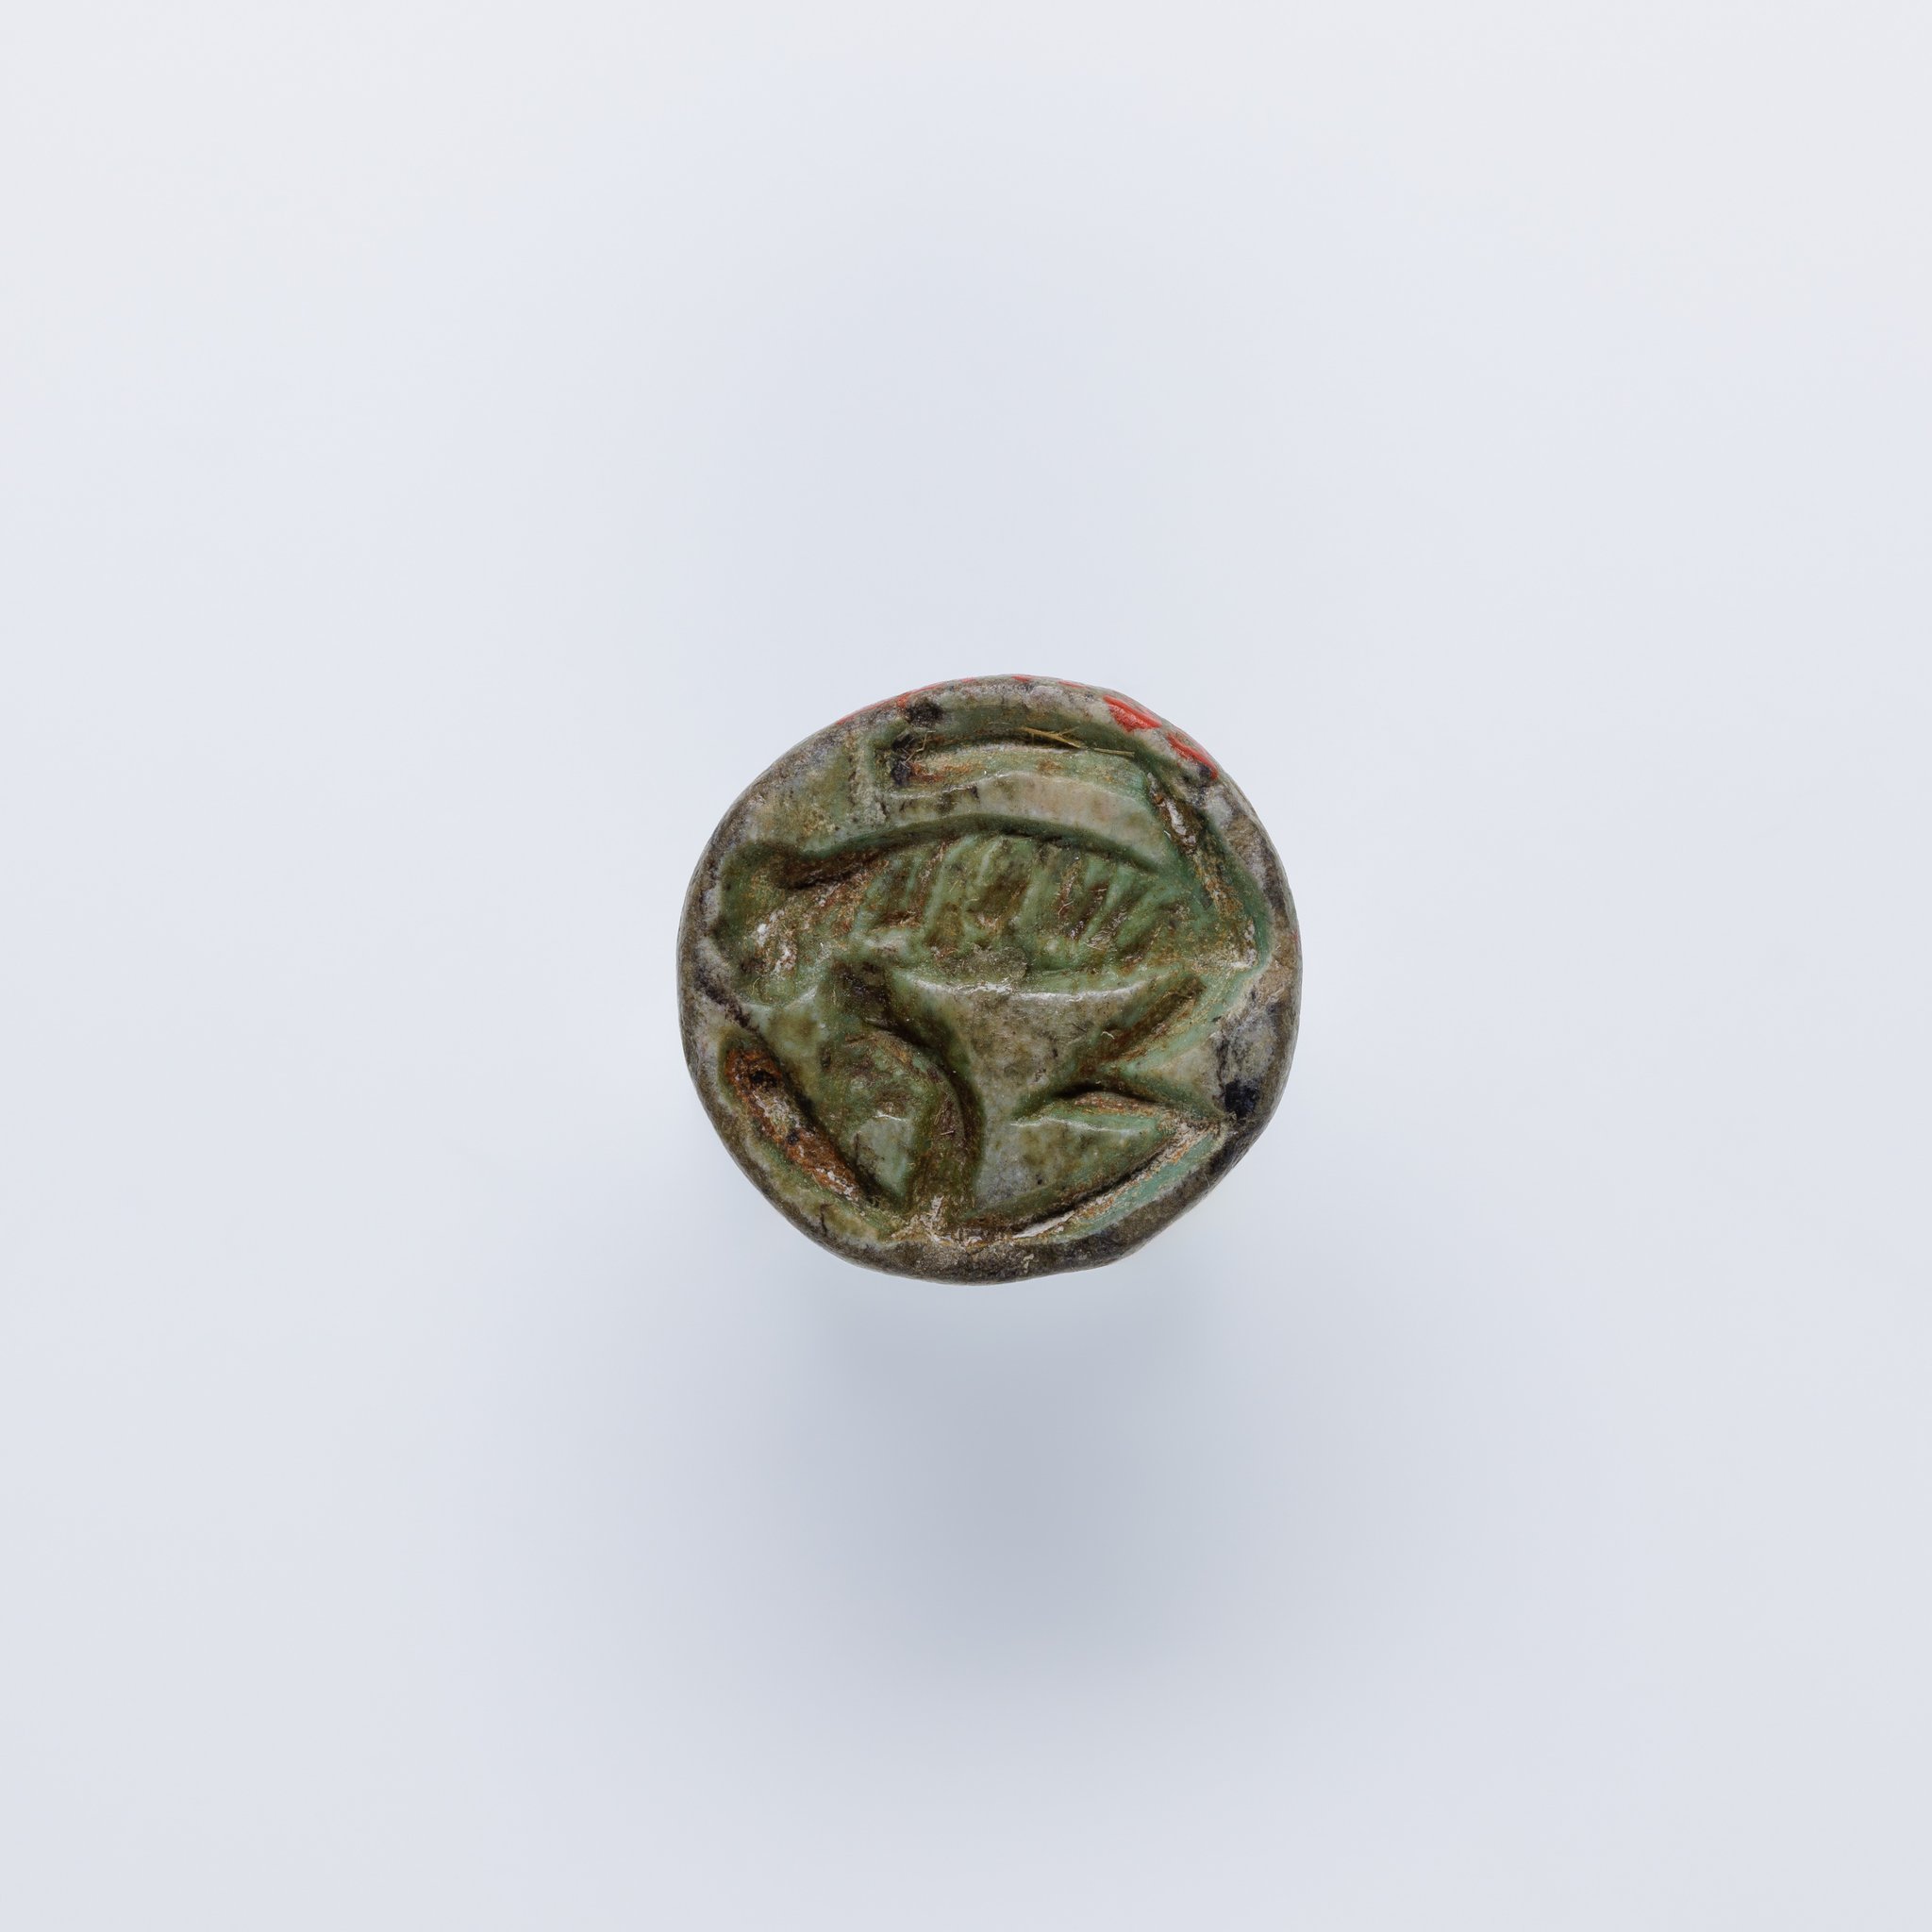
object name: design amulet, hippopotamus head, monkey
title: Design Amulet with a Hippopotamus (? ) Head on the Back Pierced for Stringing, and a Left-facing Monkey as the Device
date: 2150-2100 BCE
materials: stone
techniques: glazing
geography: egypt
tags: hippos,monkeys